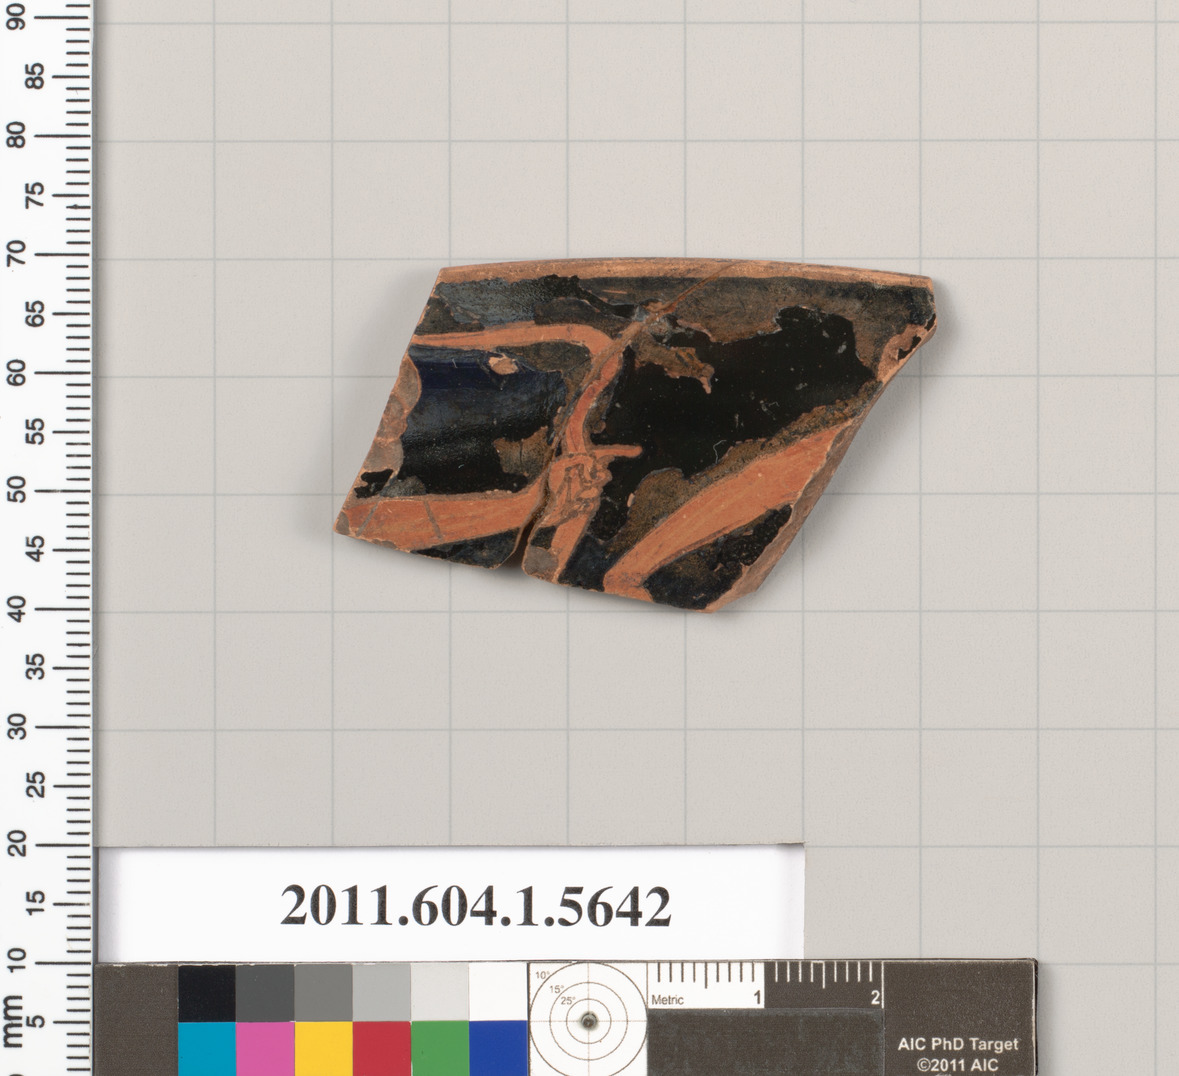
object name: kylix fragment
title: Terracotta rim fragment of a kylix (drinking cup)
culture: greek, attic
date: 490-480 BCE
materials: terracotta